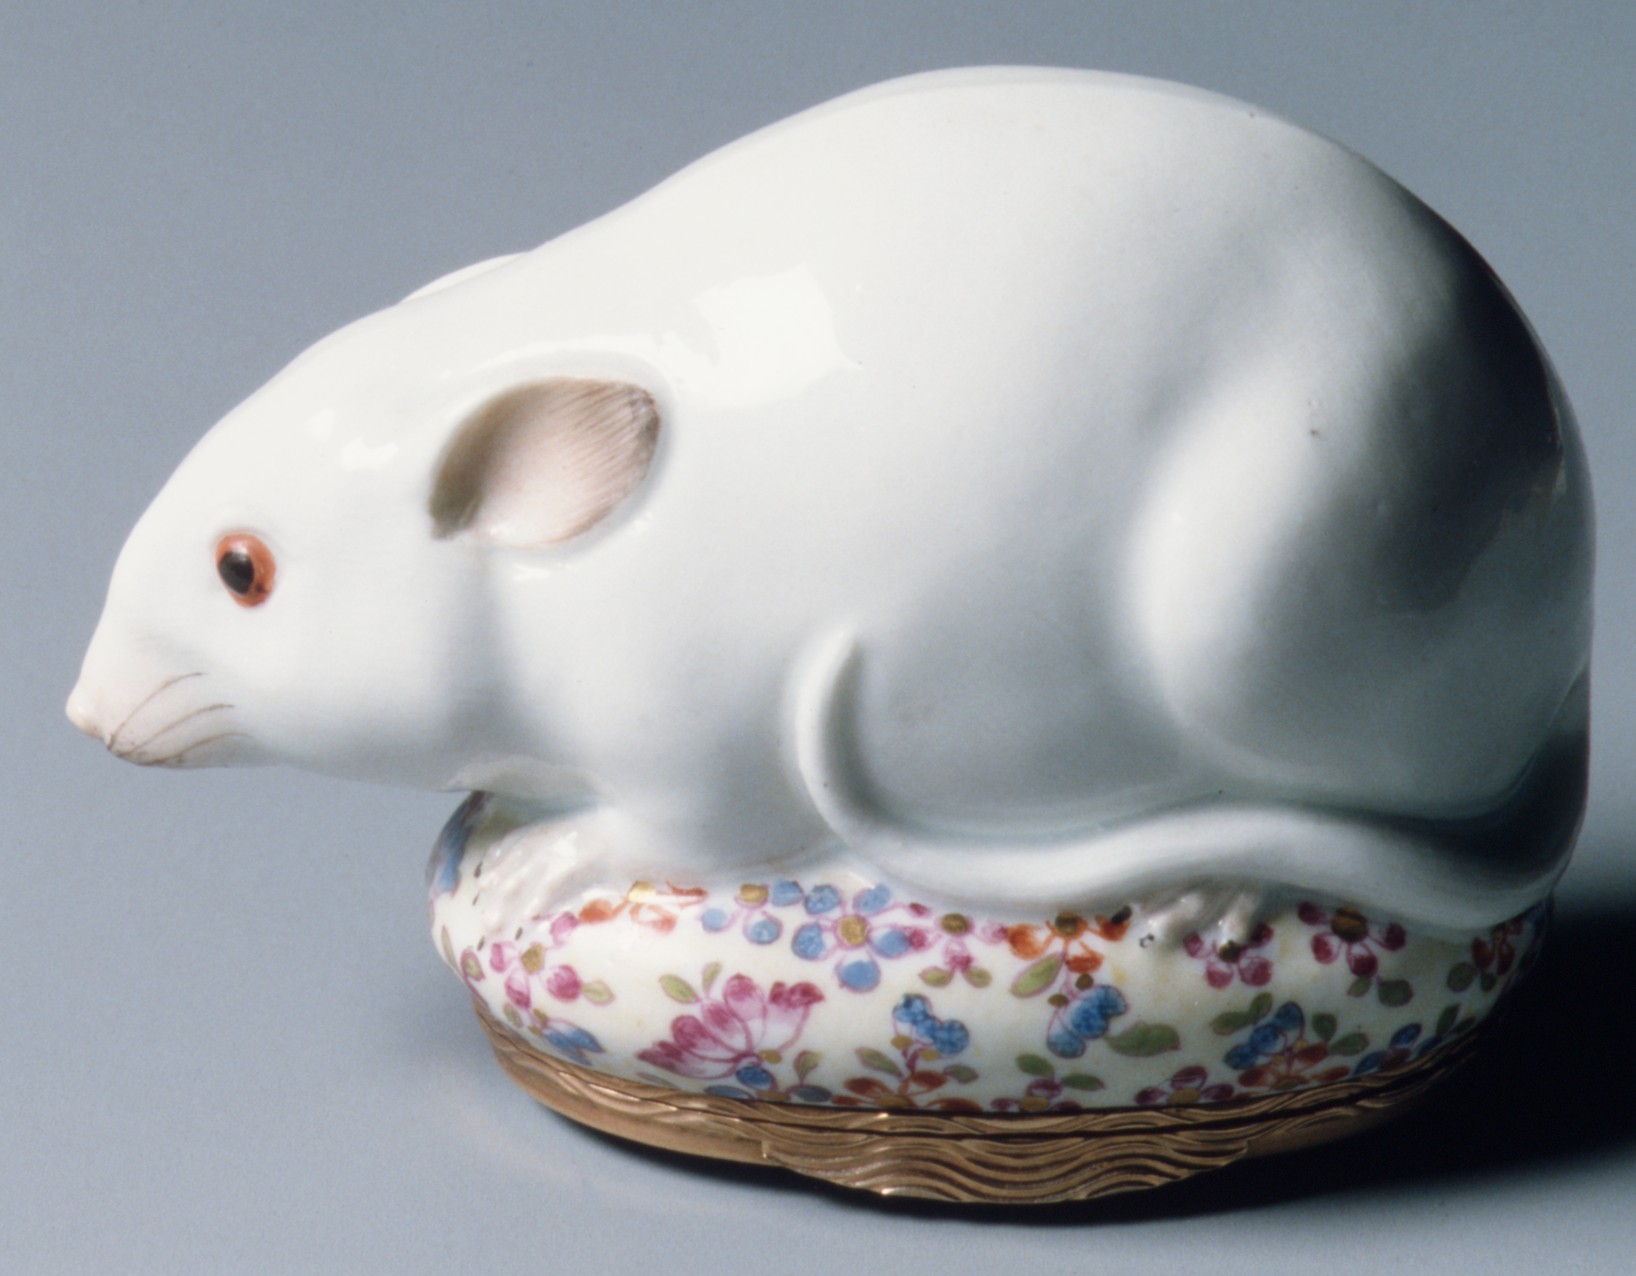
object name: snuffbox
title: Snuffbox in the form of a rat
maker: meissen manufactory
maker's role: manufactory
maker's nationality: german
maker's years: 1710-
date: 1745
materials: gold, hard paste porcelain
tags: mice